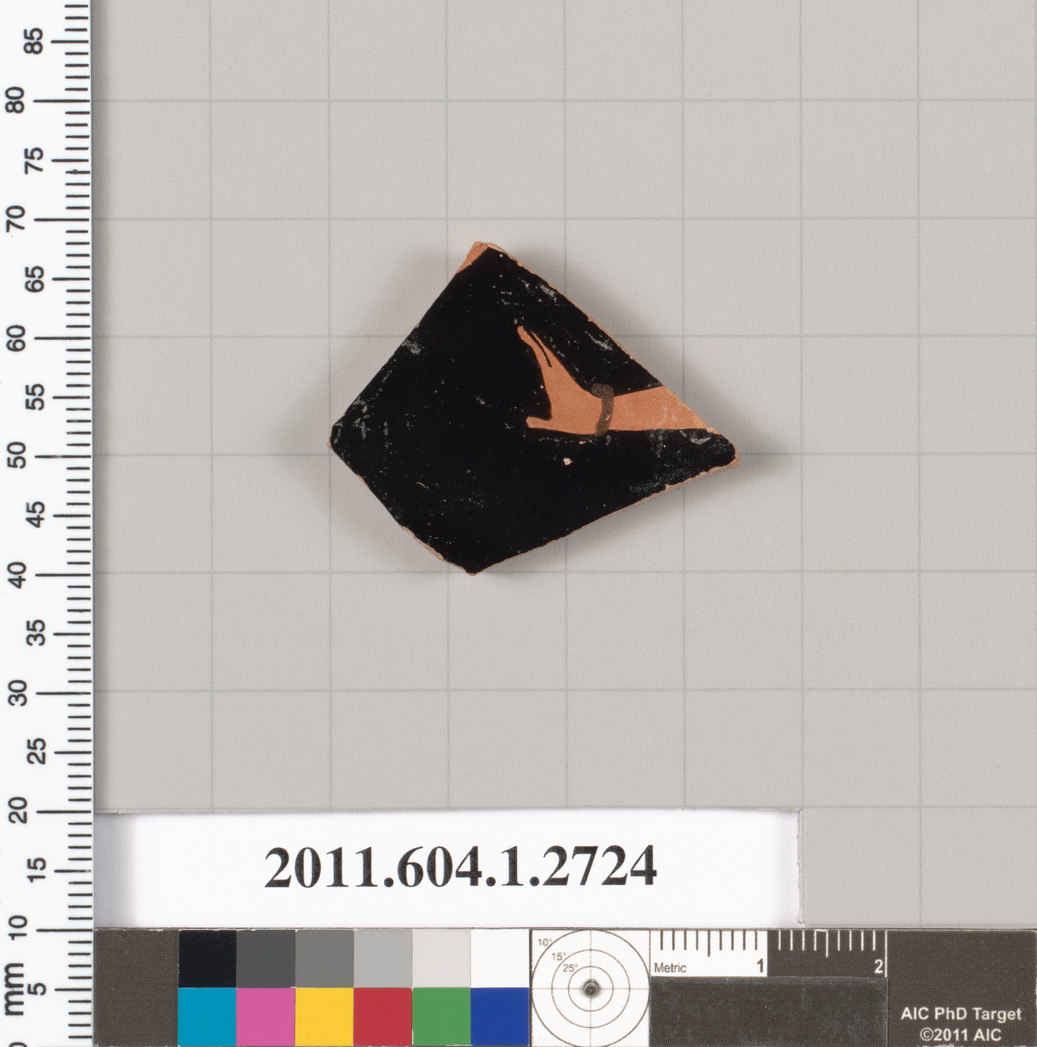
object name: kylix fragment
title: Terracotta fragment of a kylix (drinking cup)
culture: greek, attic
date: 490-480 BCE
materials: terracotta